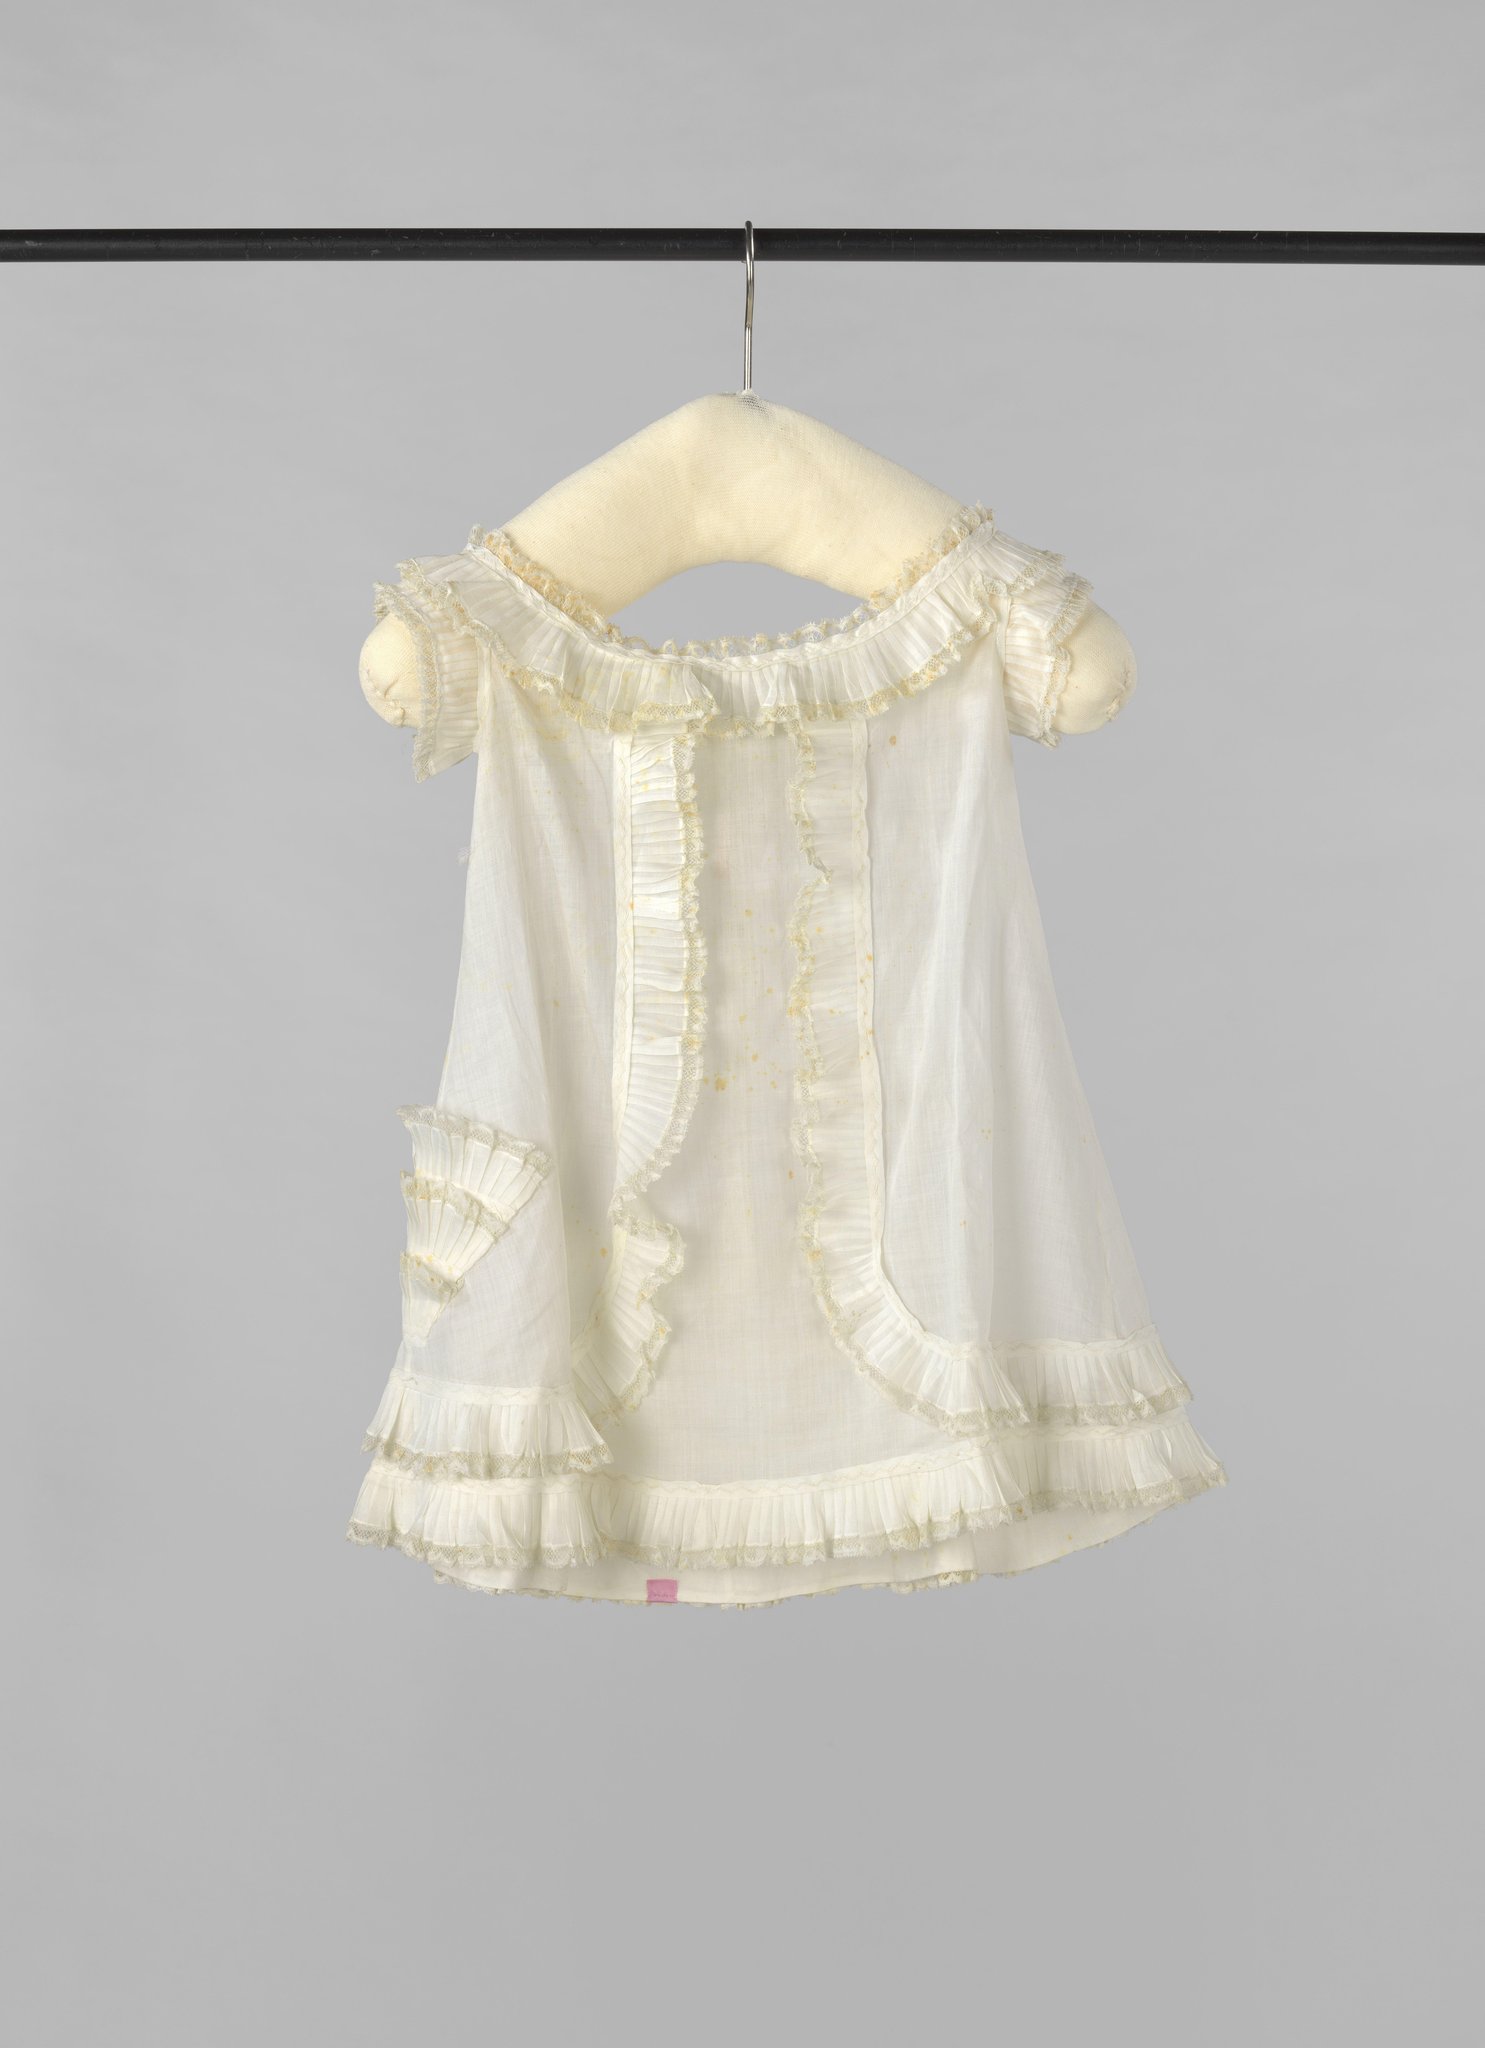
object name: main garment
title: Jurk van witte batist met versiering van geplisseerde stroken met geschulpte kant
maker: Anonymous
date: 1890-1930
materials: textile, cotton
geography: netherlands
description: Jurk van witte batist. Model: prinsesselijn, wijde ronde hals, met stroken aangezette mouwen. Versiering: geplisseerde stroken waarlangs geschulpte rand van kant zijn middels een bandje met een siersteek op de jurk bevestigd langs de hals, langs de voornaden weglopend naar achter, langs de onderrand en tenslotte op de achterkant van de rok bij wijze van queue. Op het jurkje een V-vormig zakje van stroken. Aan achterzijde blinde sluiting met vier knopen en lusjes. Aan binnenzijde is een stukje paars-roze lint genaaid. Op label: Jiskoot-Pierson, Baarn.